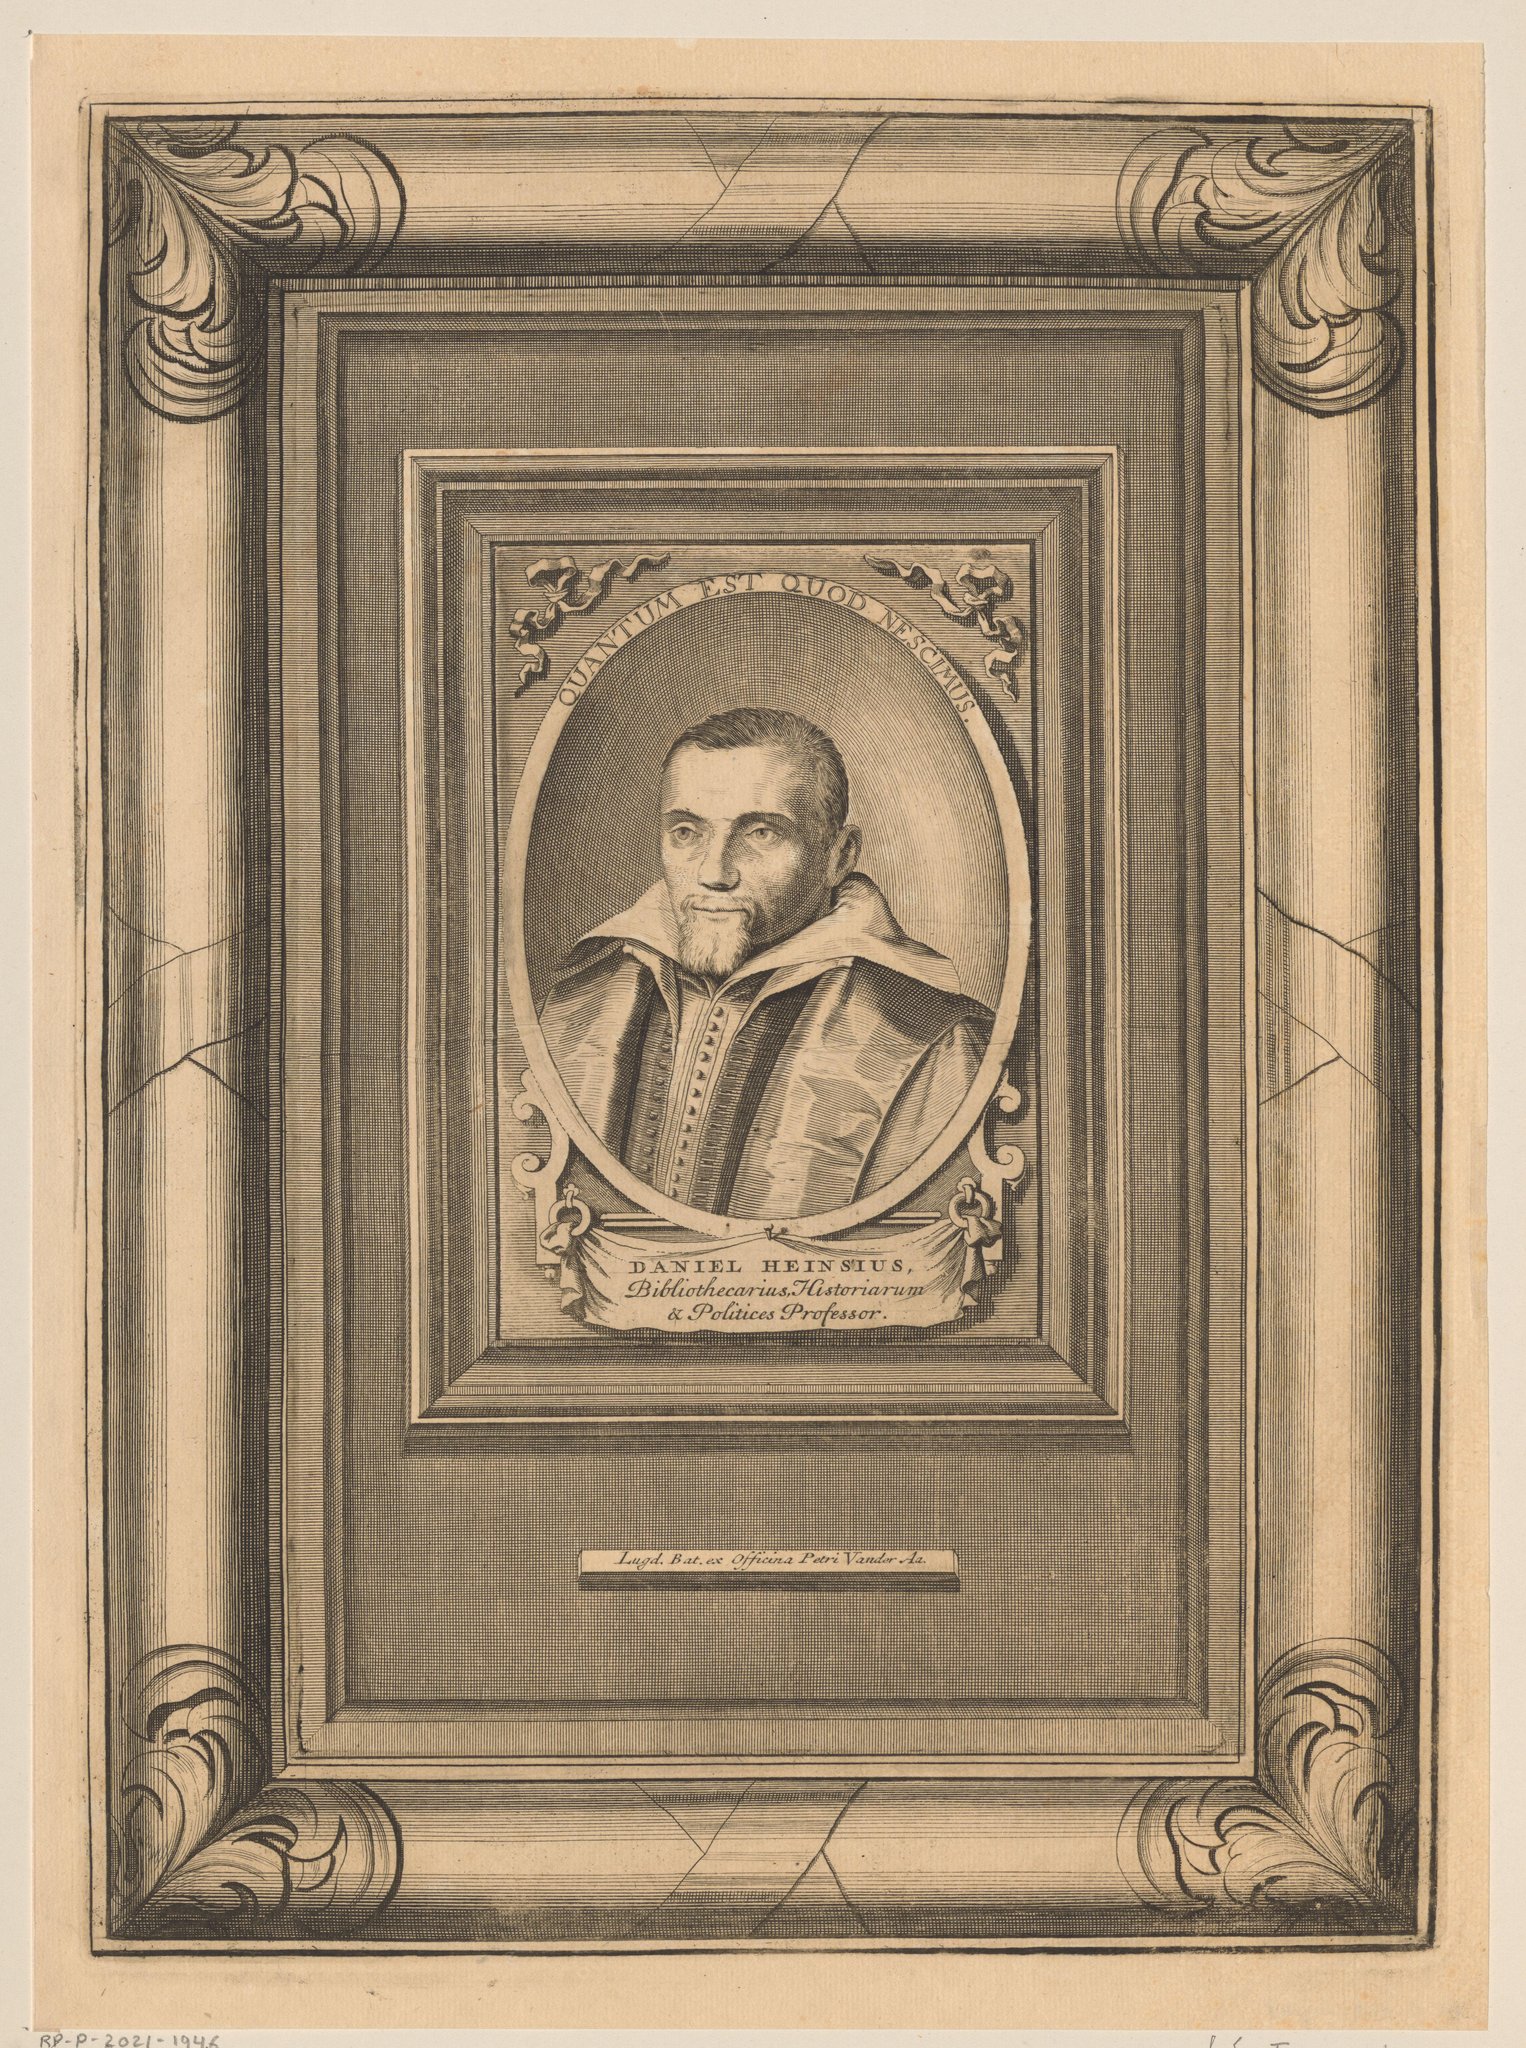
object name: print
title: Icones ad vivum delineatae et expressae virorum clariorum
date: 1609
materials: paper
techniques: engraving, etching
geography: leiden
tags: ghent, daniël heinsius, historical persons, professor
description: Prent met enkele omlijsting gebruikt in: Fundatoris curatorum et professorum celeberrimorum aliorumque illustrium virorum (...). Leiden: Pieter van der Aa, ca. 1716. Eerdere staat van het portret gebruikt in: Meursius, Joannes. Icones ad vivum delineatae et expressae. Leiden: Andries Clouck, 1609.